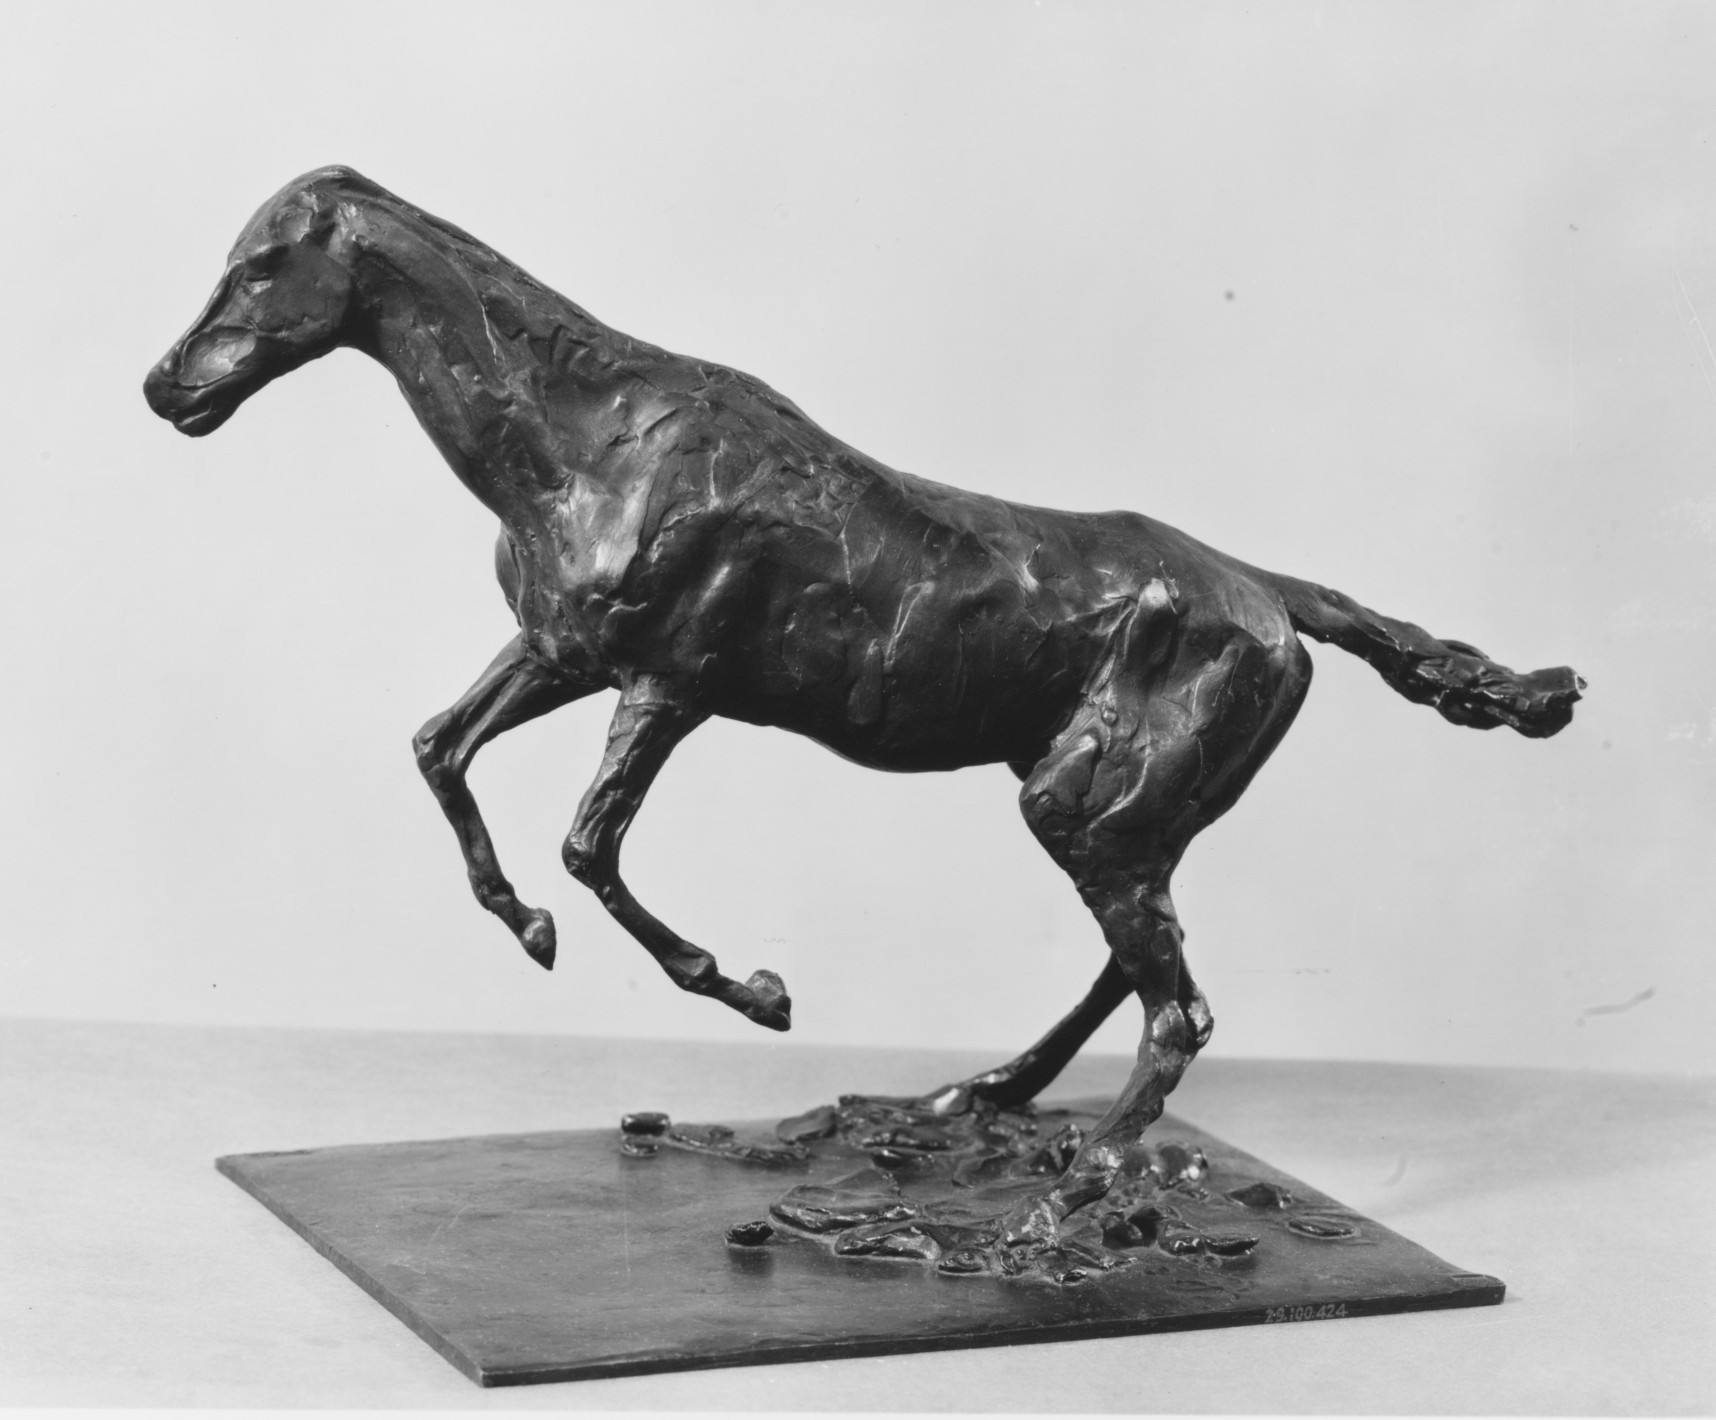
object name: statuette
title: Horse Balking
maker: edgar degas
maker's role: artist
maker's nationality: french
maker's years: 1834-1917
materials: bronze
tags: horses